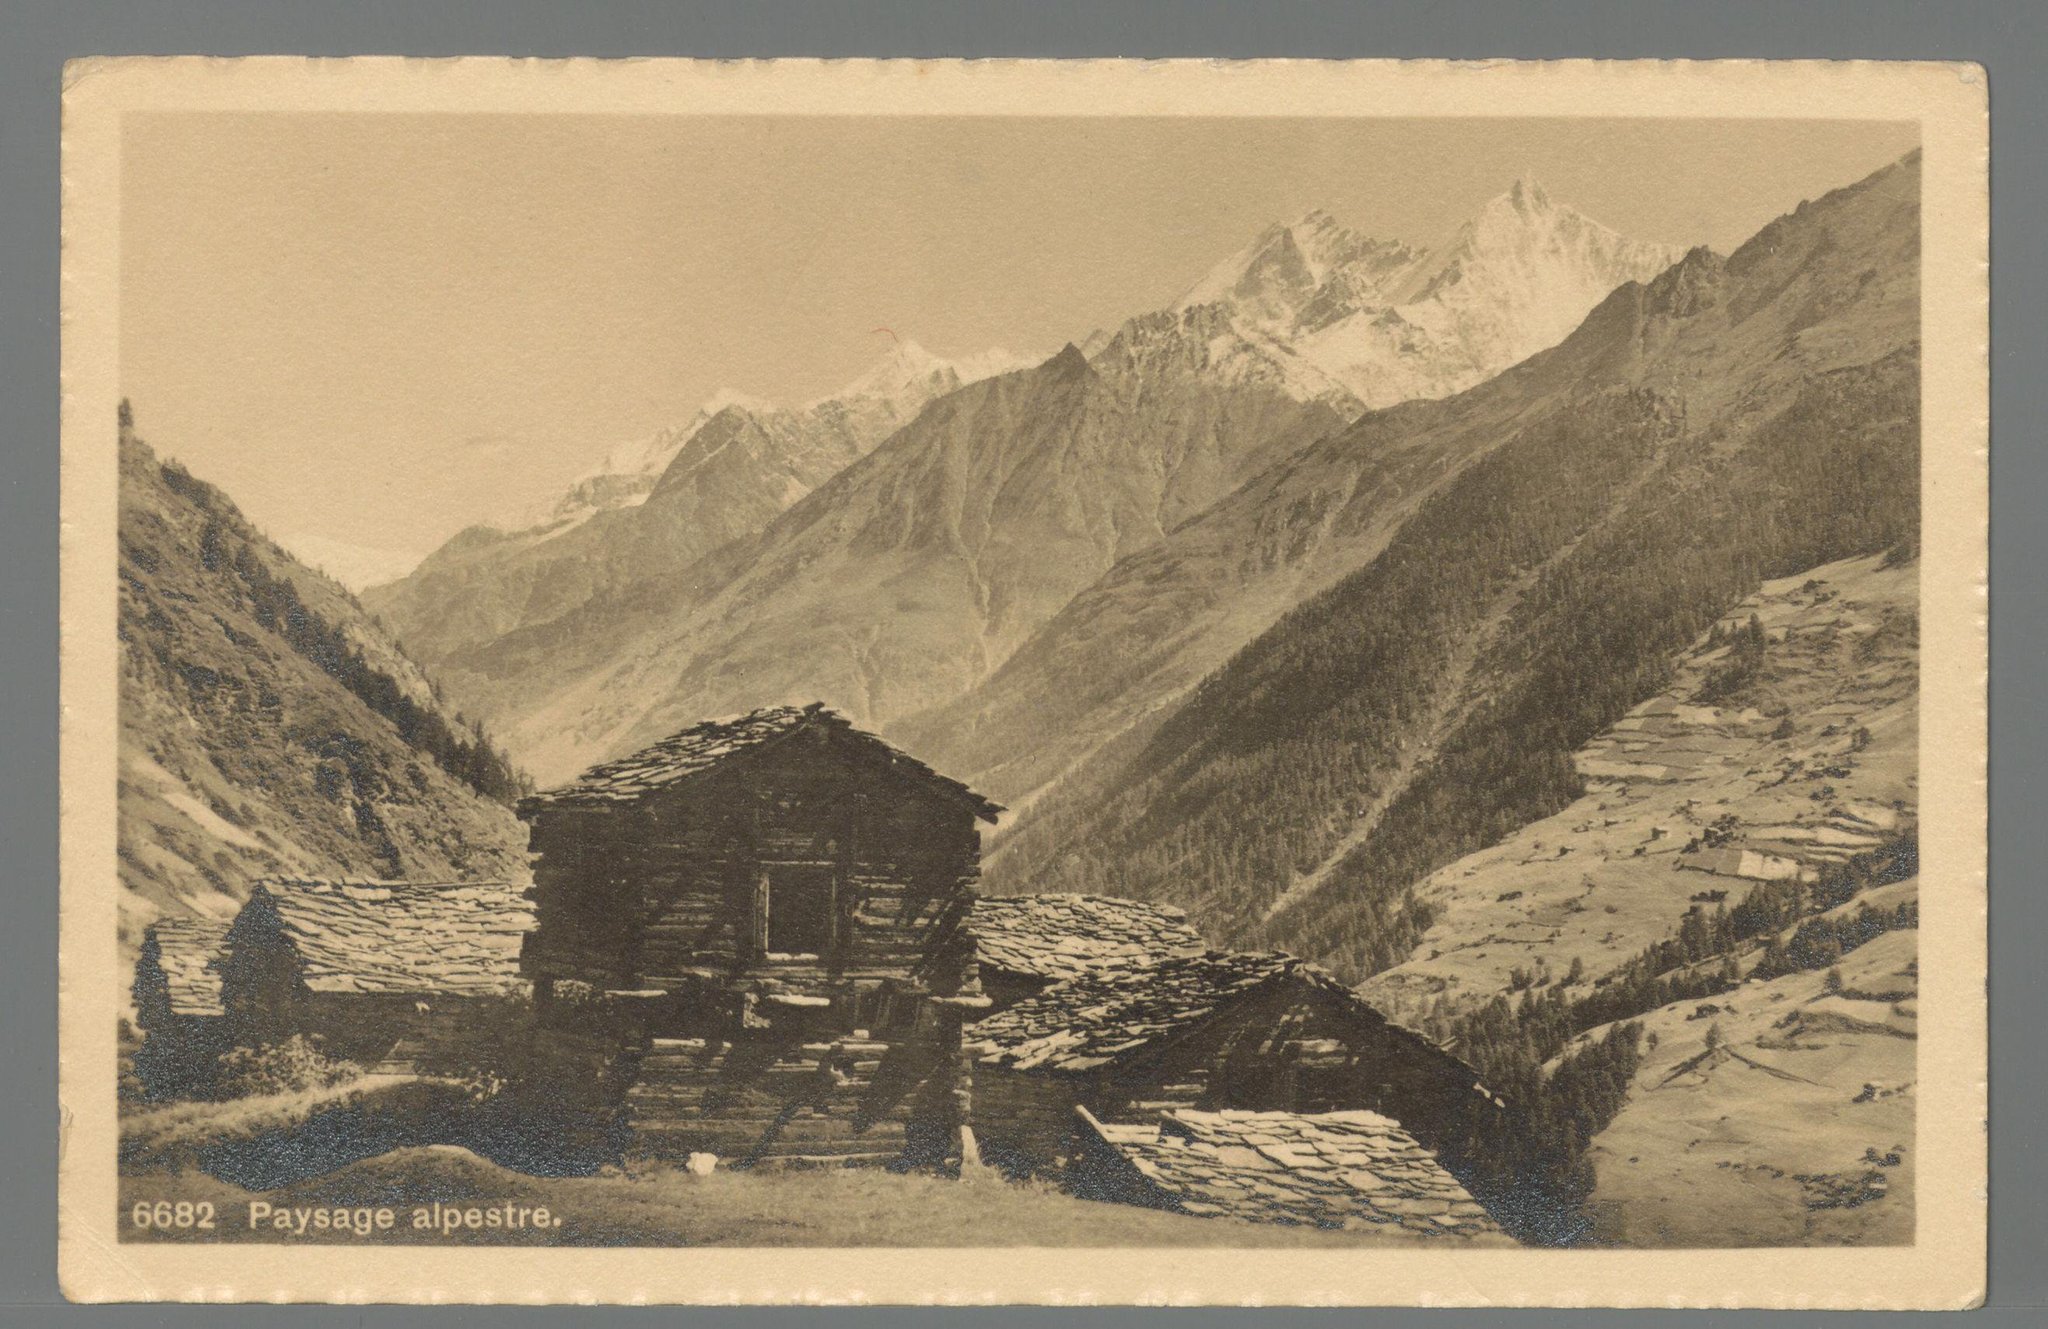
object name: ansichtkaart, prentbriefkaart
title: Paysage alpestre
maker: Anonymous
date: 1905-1911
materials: photographic support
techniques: photography, writing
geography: switzerland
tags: rural housing, e.g. country-house, villa, cottage, mountain-range, snow peaks, switzerland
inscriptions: postage stamp